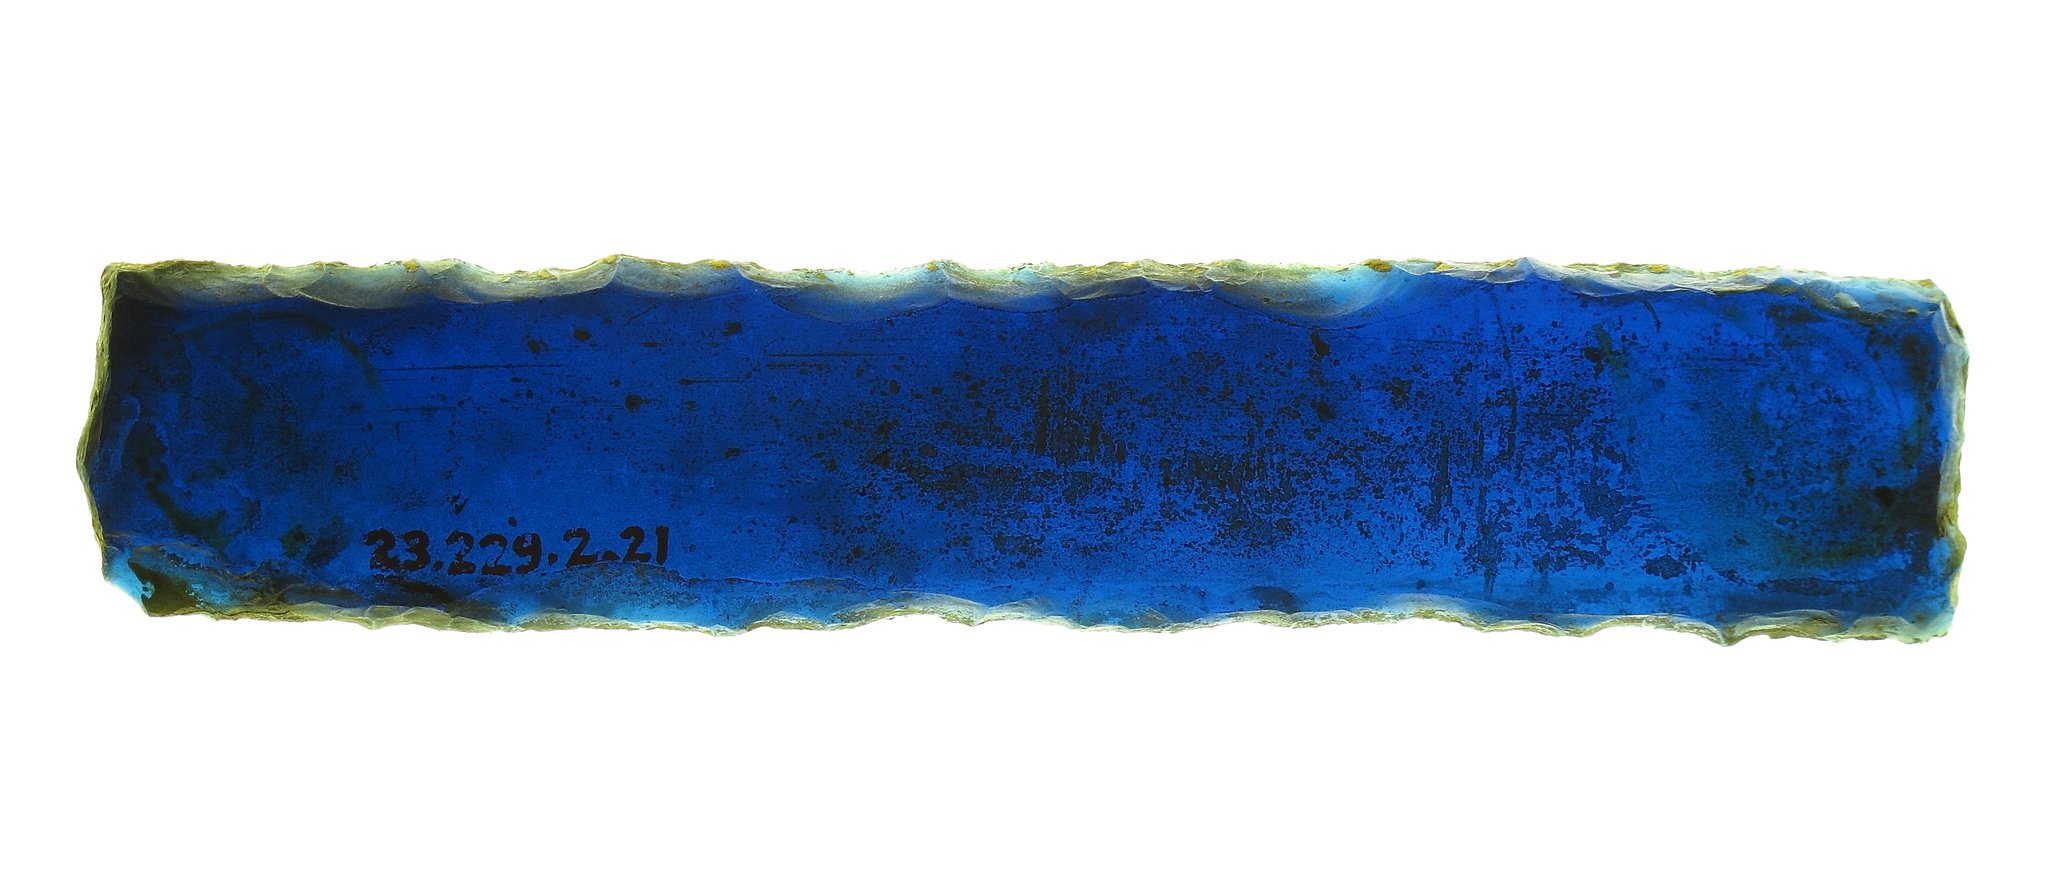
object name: fragment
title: Glass Fragment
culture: french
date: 1201-1300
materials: glass, metal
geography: france